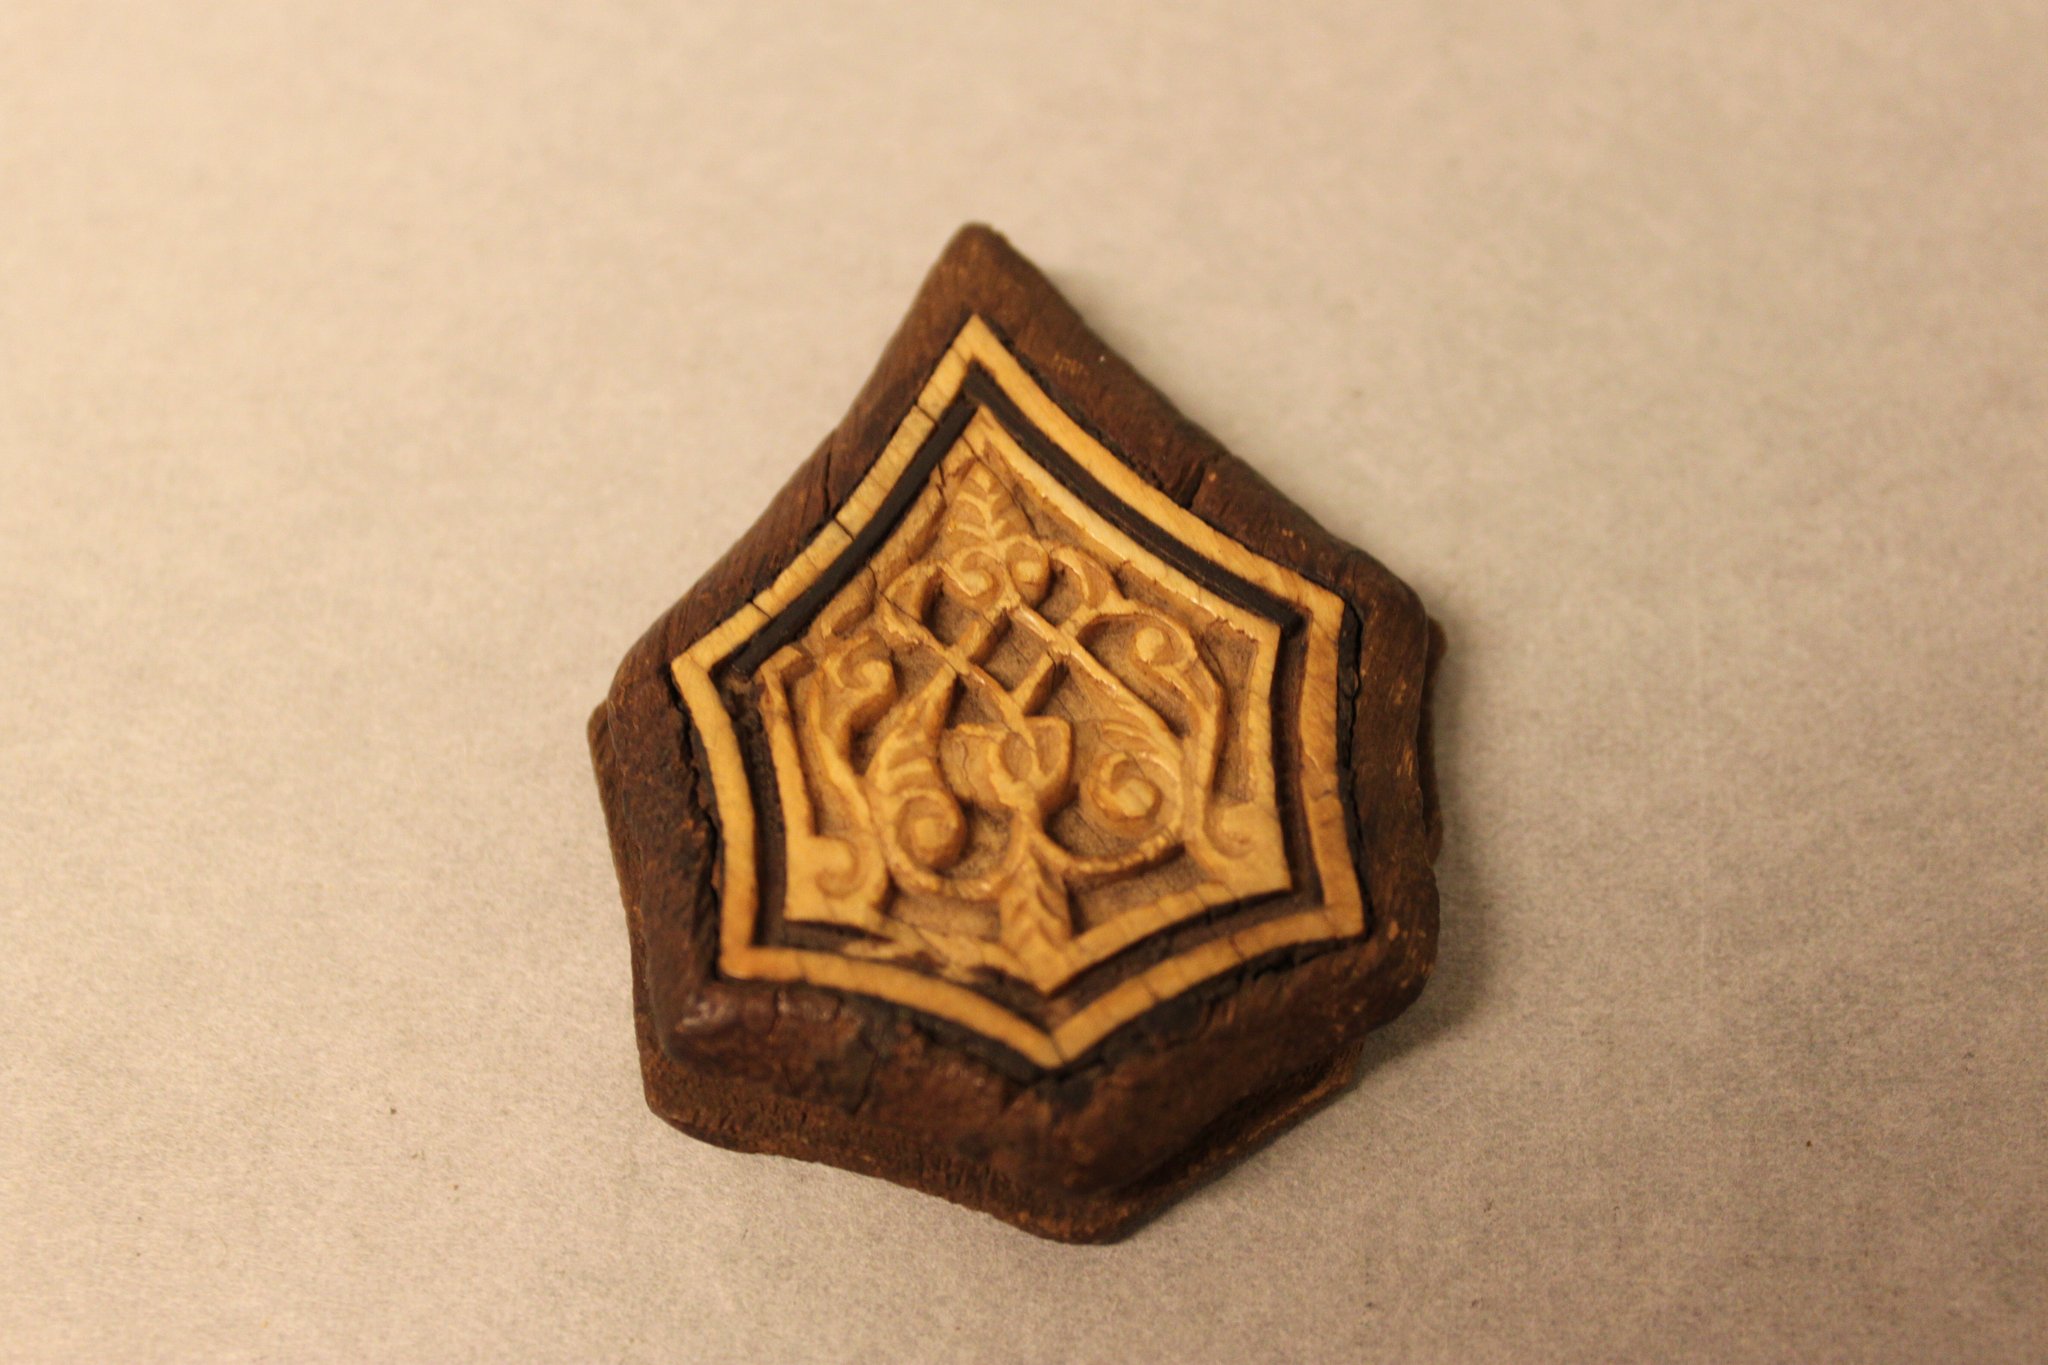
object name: panel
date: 1201-1300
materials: ivory, wood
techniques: inlay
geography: egypt